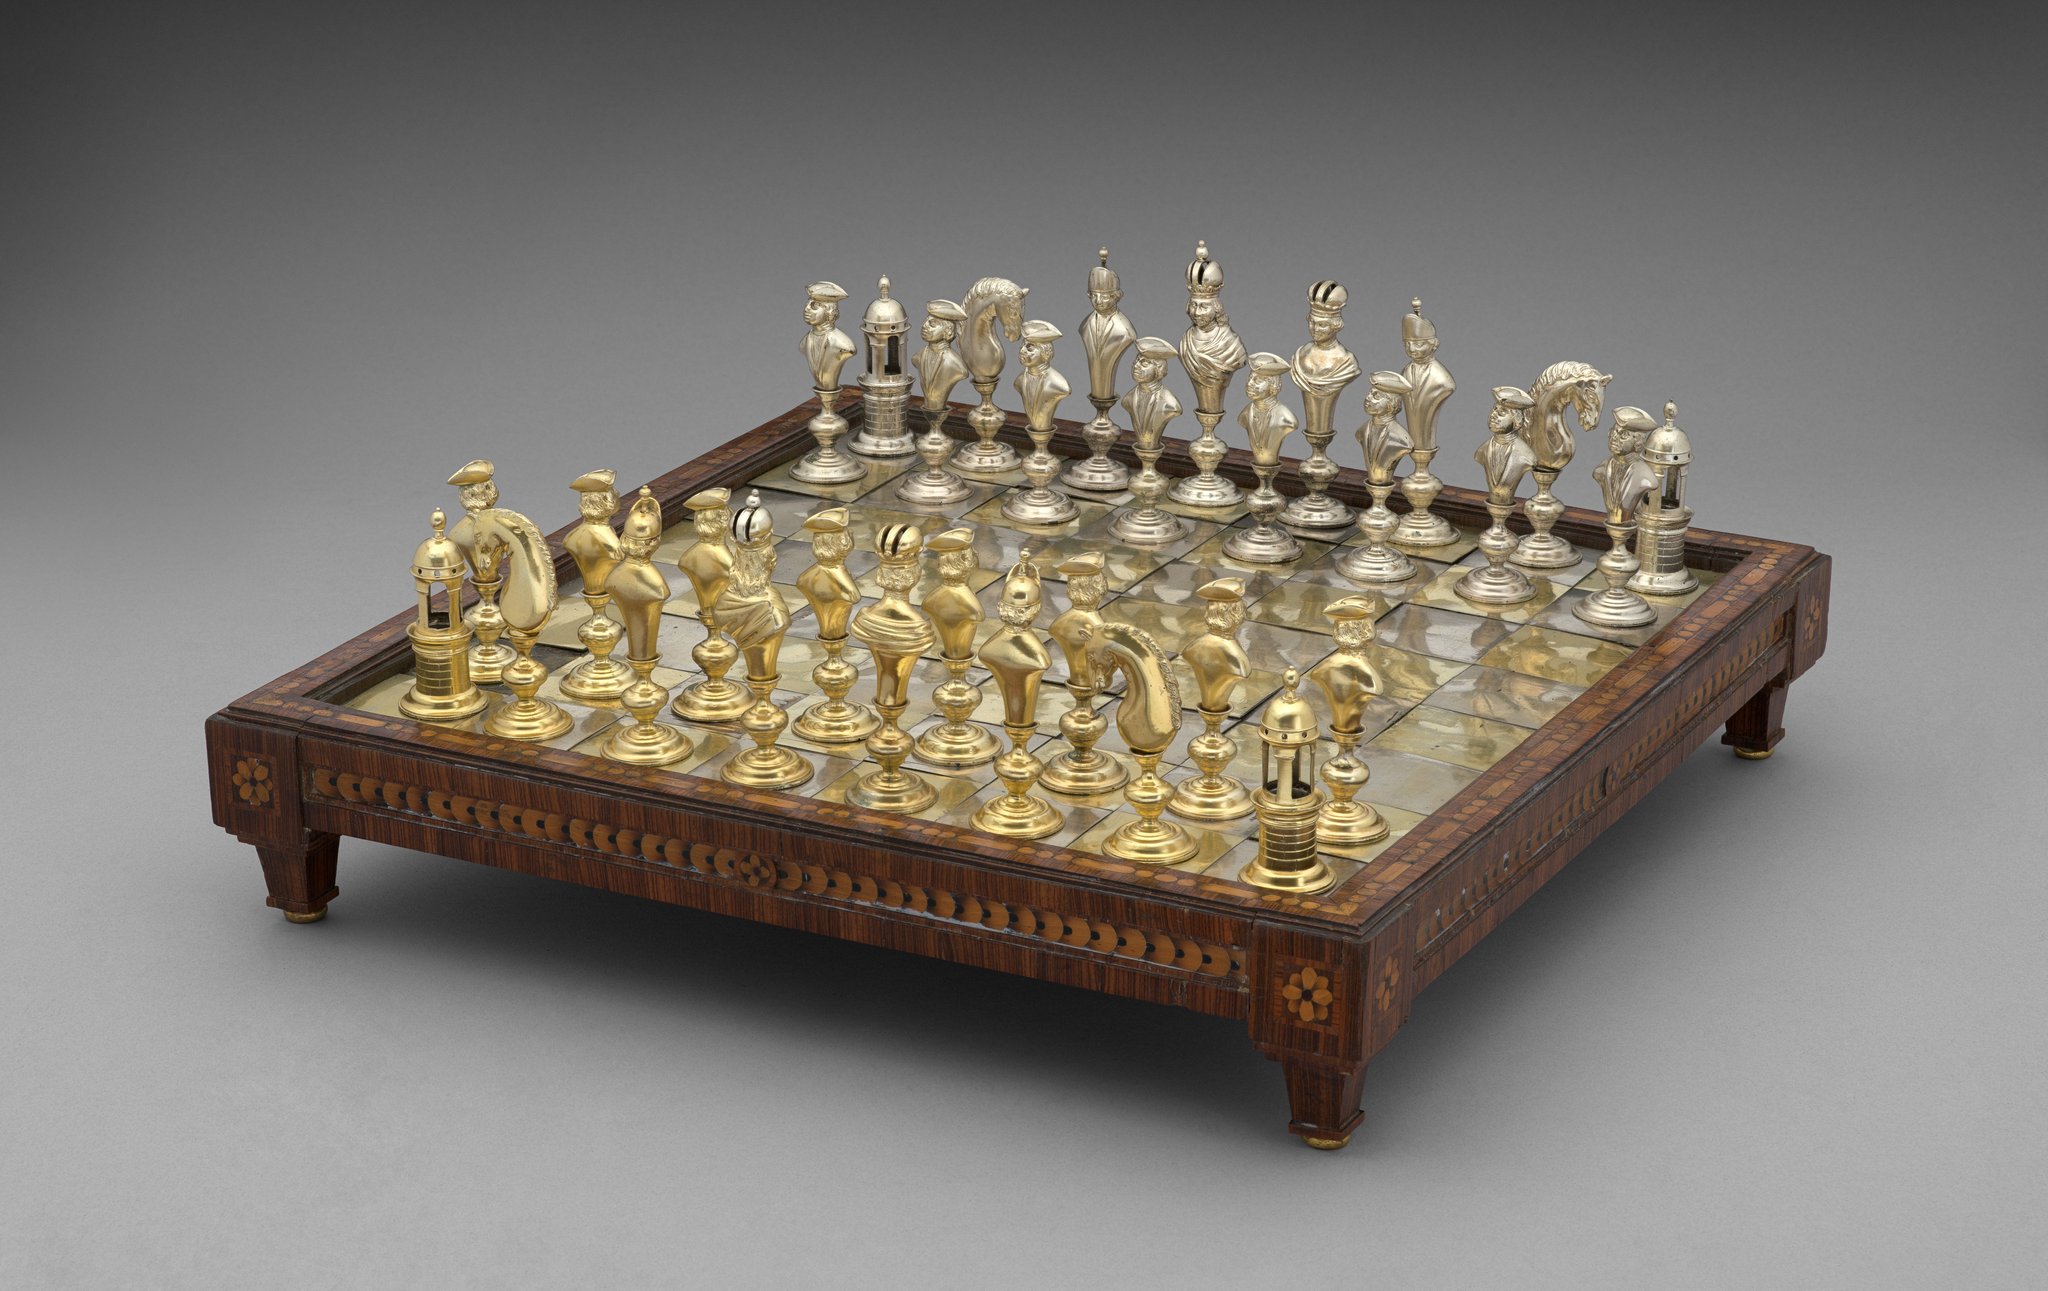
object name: chess set and box board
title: Chess set and board with box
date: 1767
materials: gold, leather, silver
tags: games